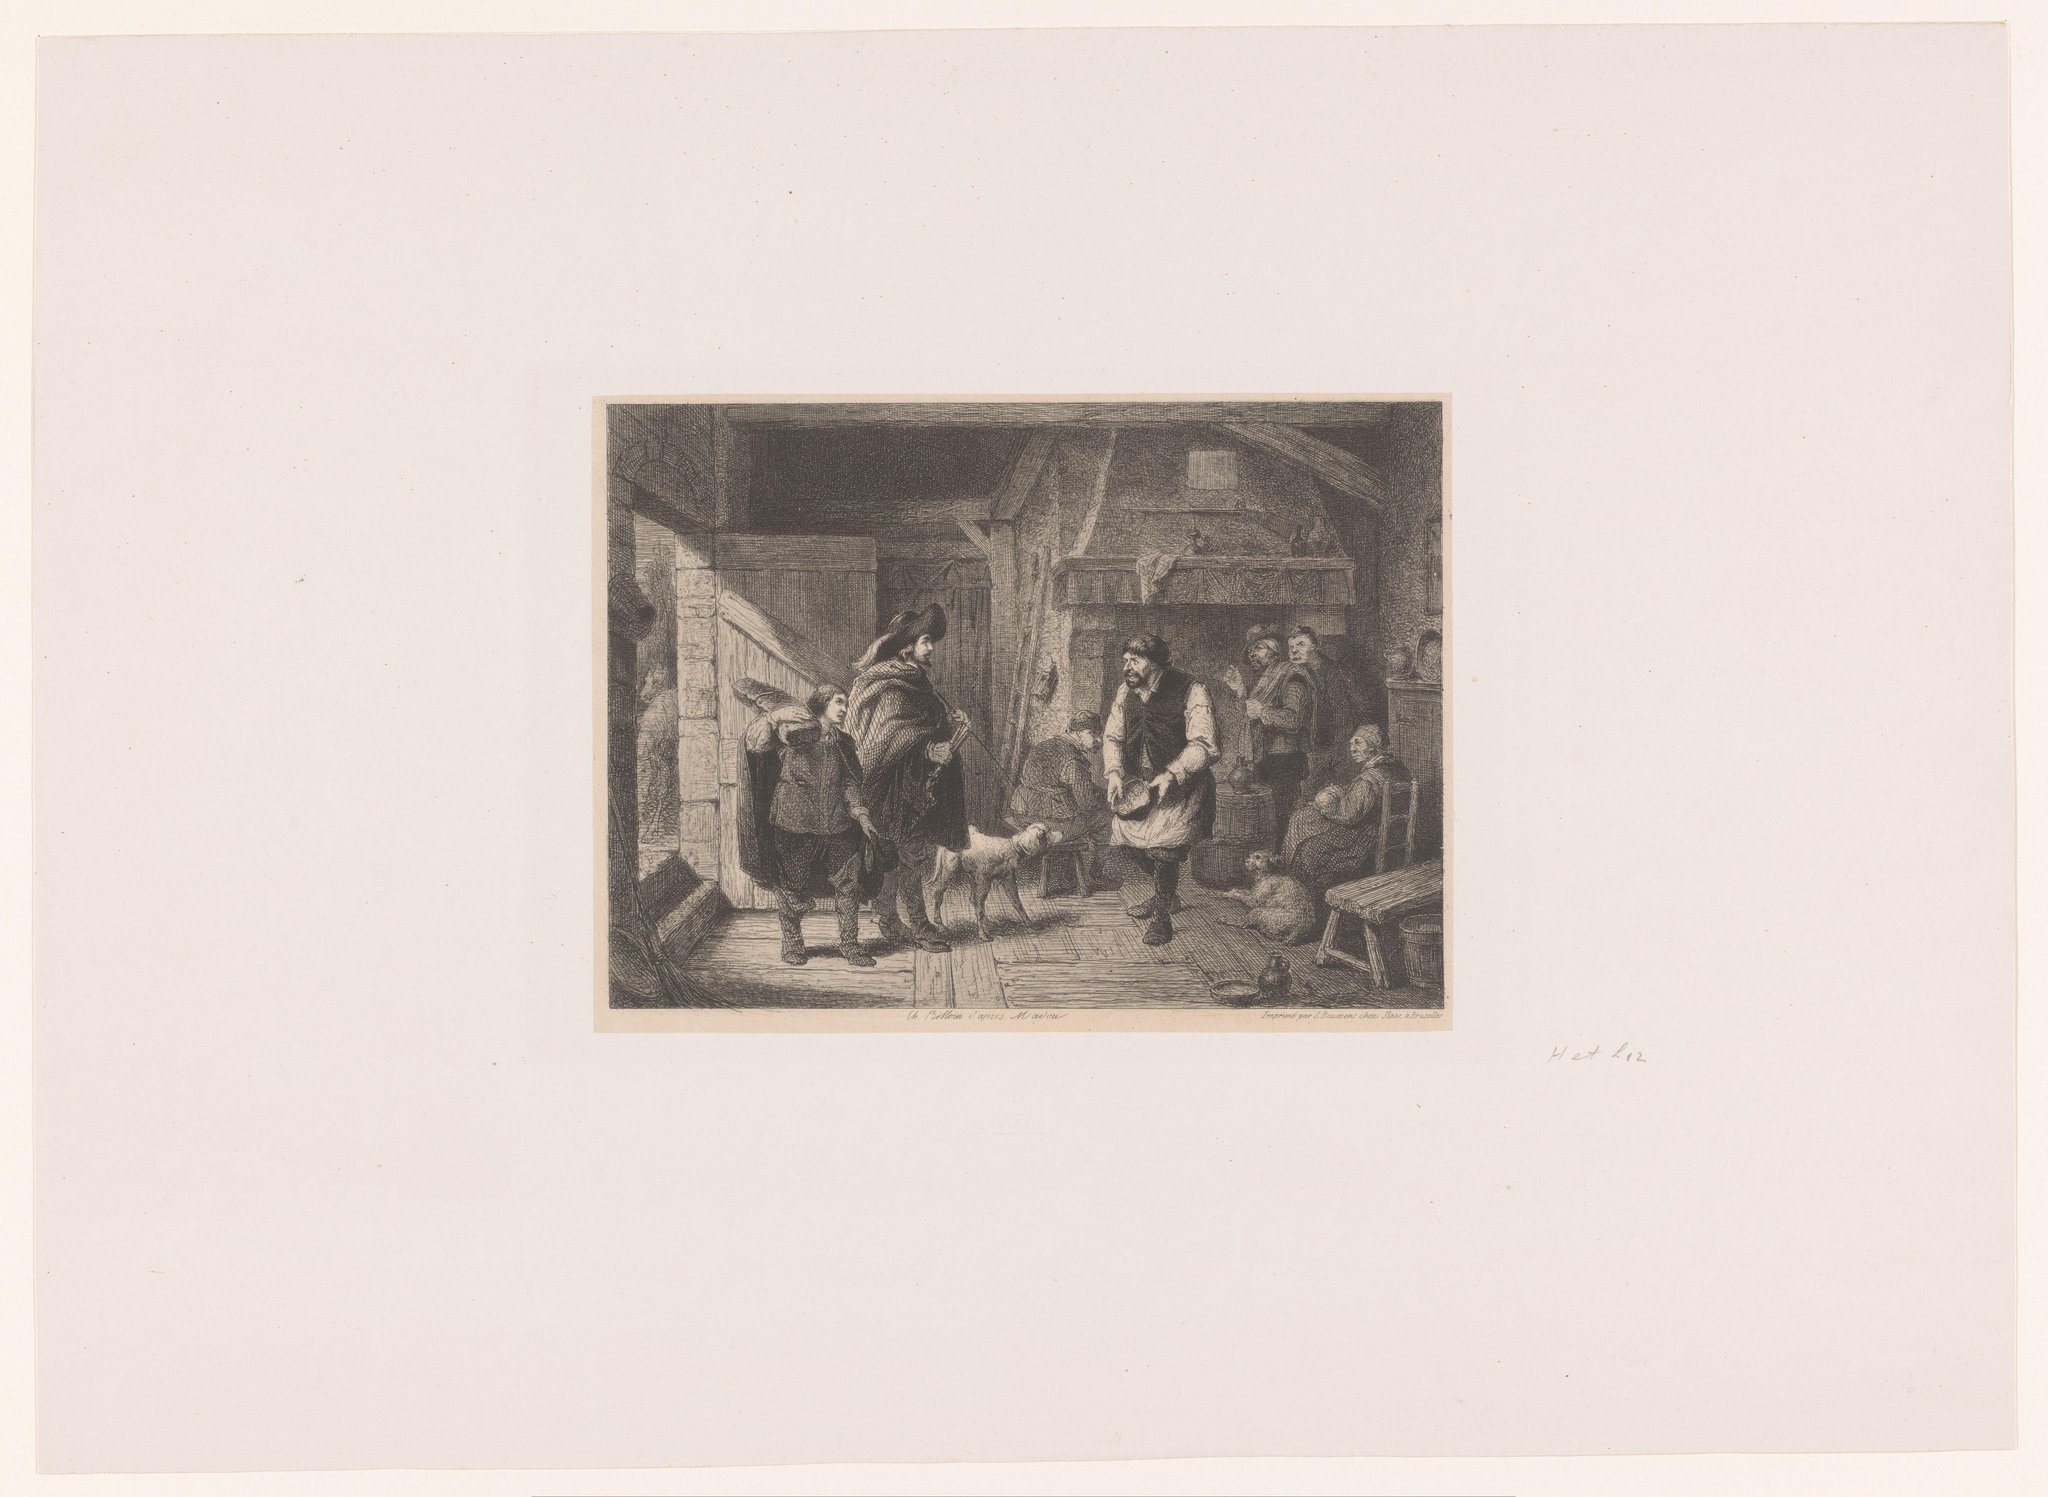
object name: print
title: Reiziger en zijn page komen de herberg binnen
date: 1823-1869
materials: paper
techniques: etching, intaglio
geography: brussels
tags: being welcomed ~ travelling, hotel, hostelry, inn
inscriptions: collector's mark: Lugt 2228, collector's mark: Lugt 2165